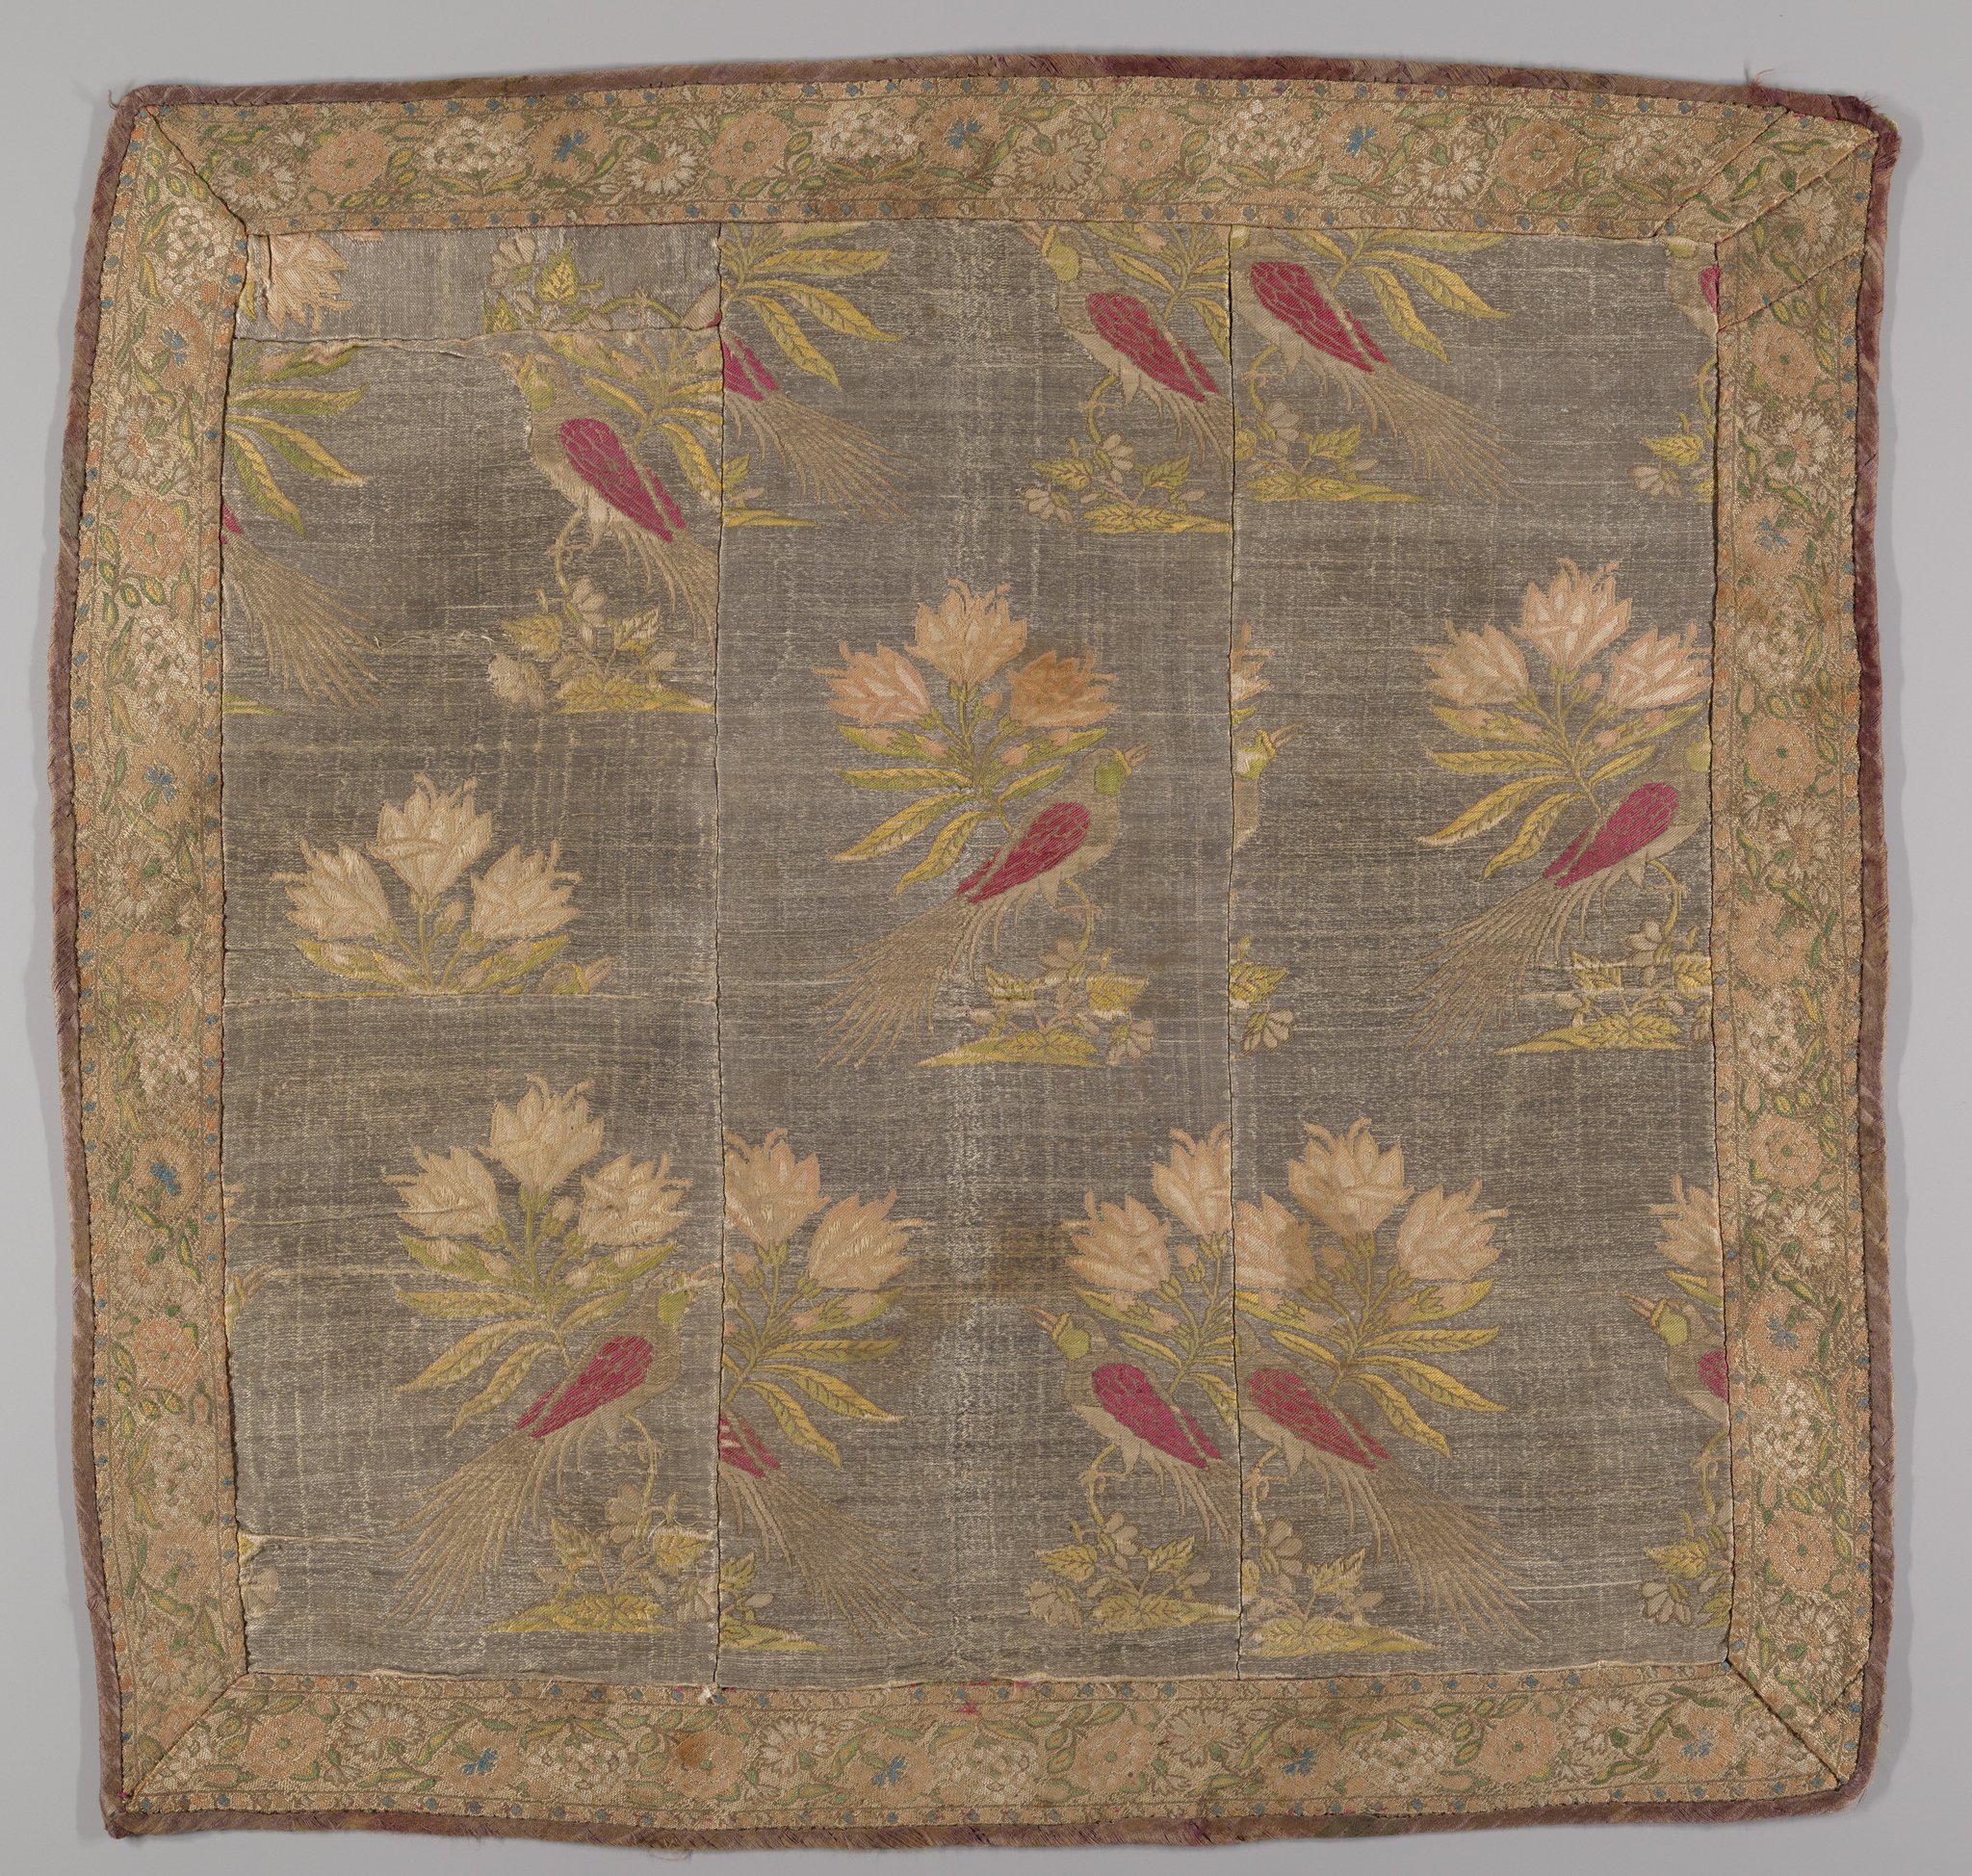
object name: square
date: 1601-1700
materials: metal thread, silk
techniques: brocade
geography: iran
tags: flowers